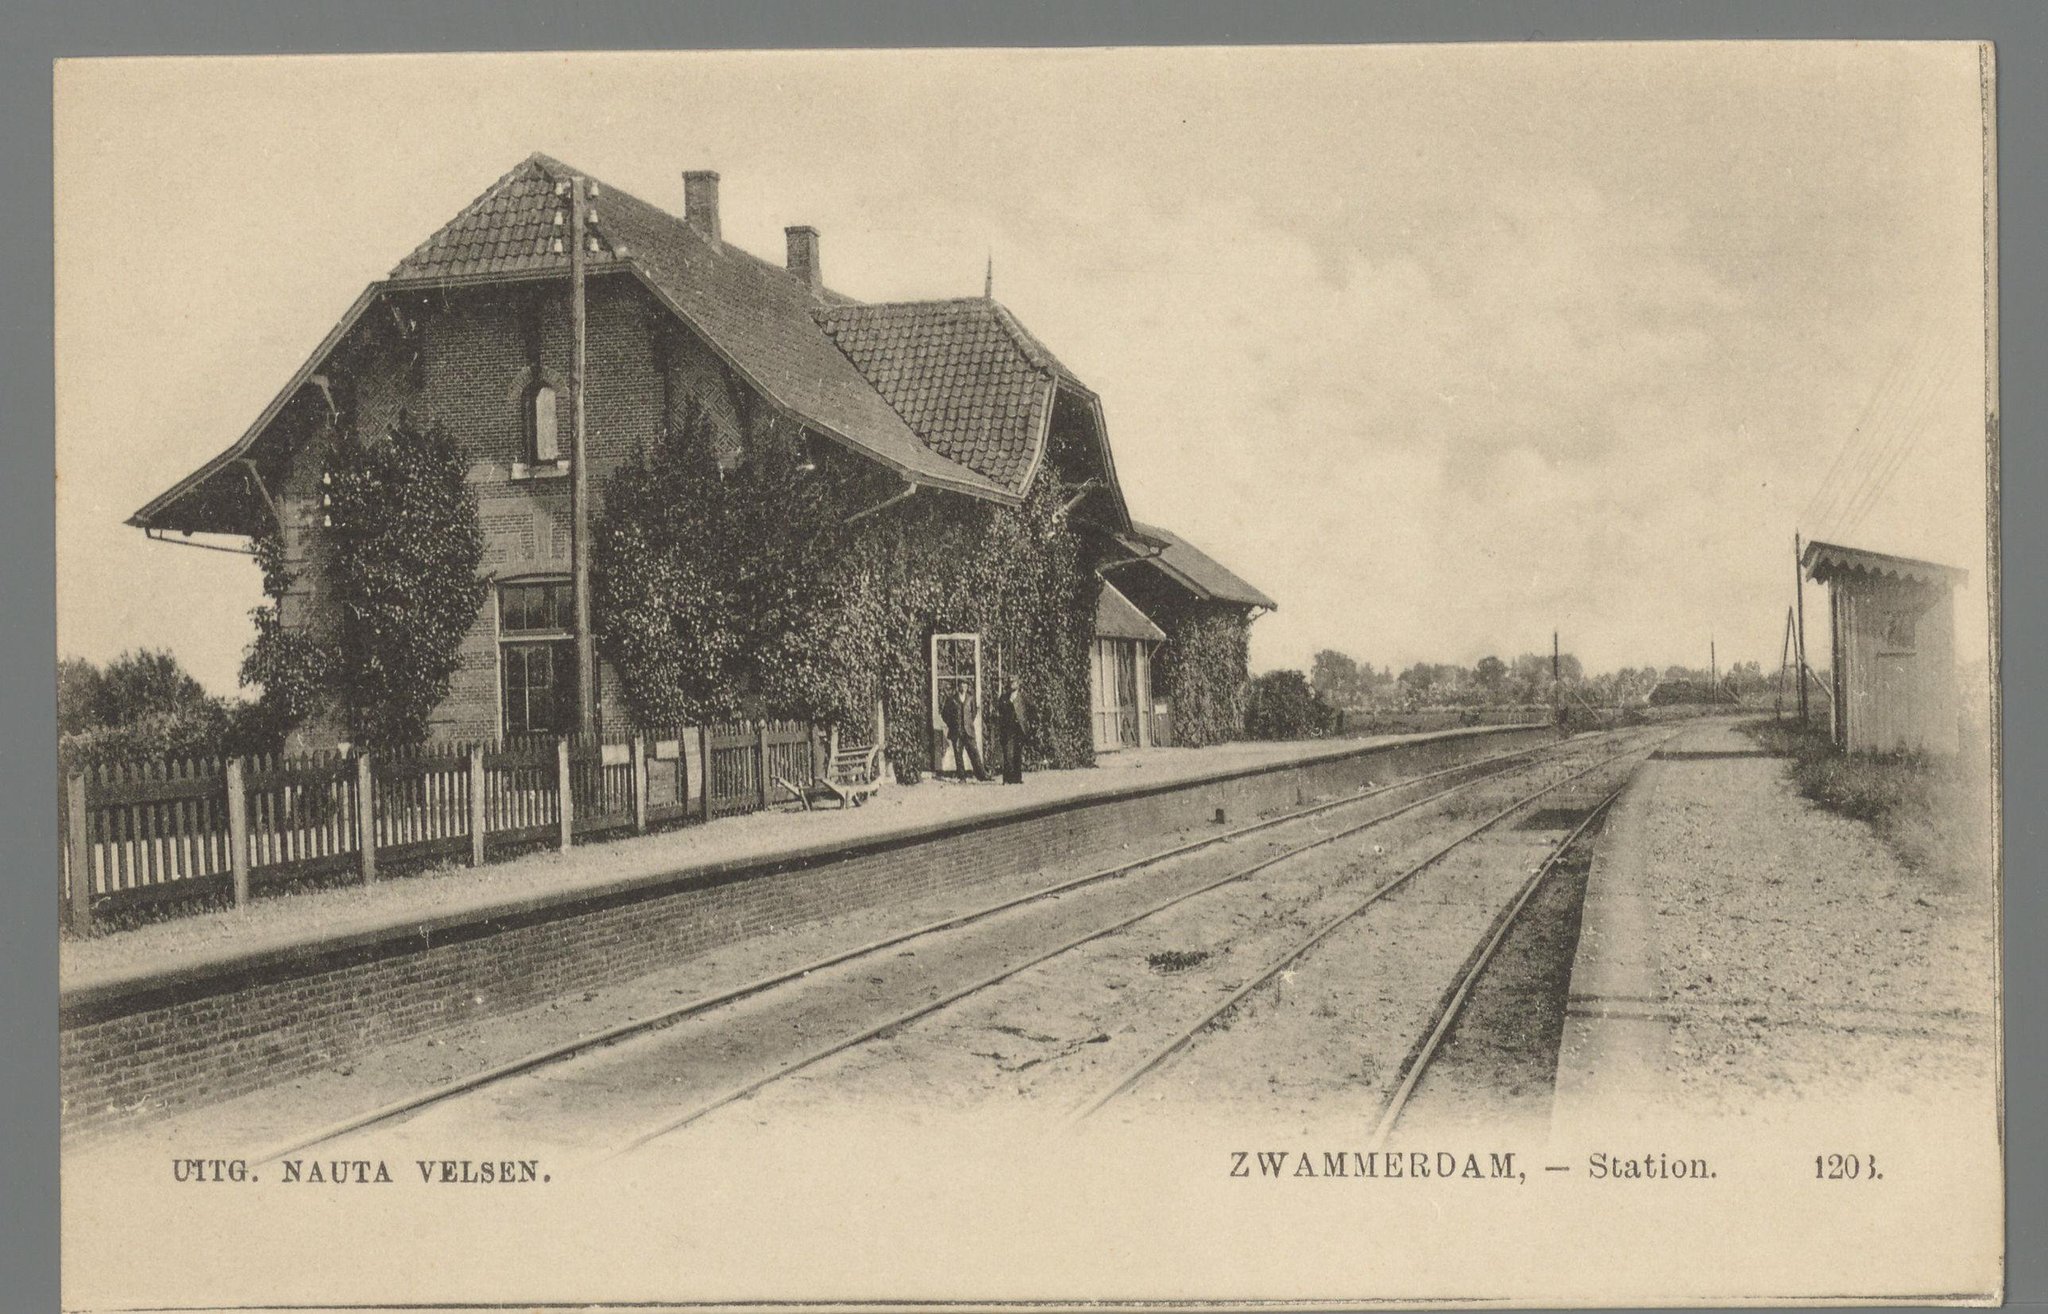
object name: photomechanical print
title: Zwammerdam, - station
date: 1897-1905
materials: cardboard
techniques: photograph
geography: velsen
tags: railway, train, station; shelter (railway, tramway)